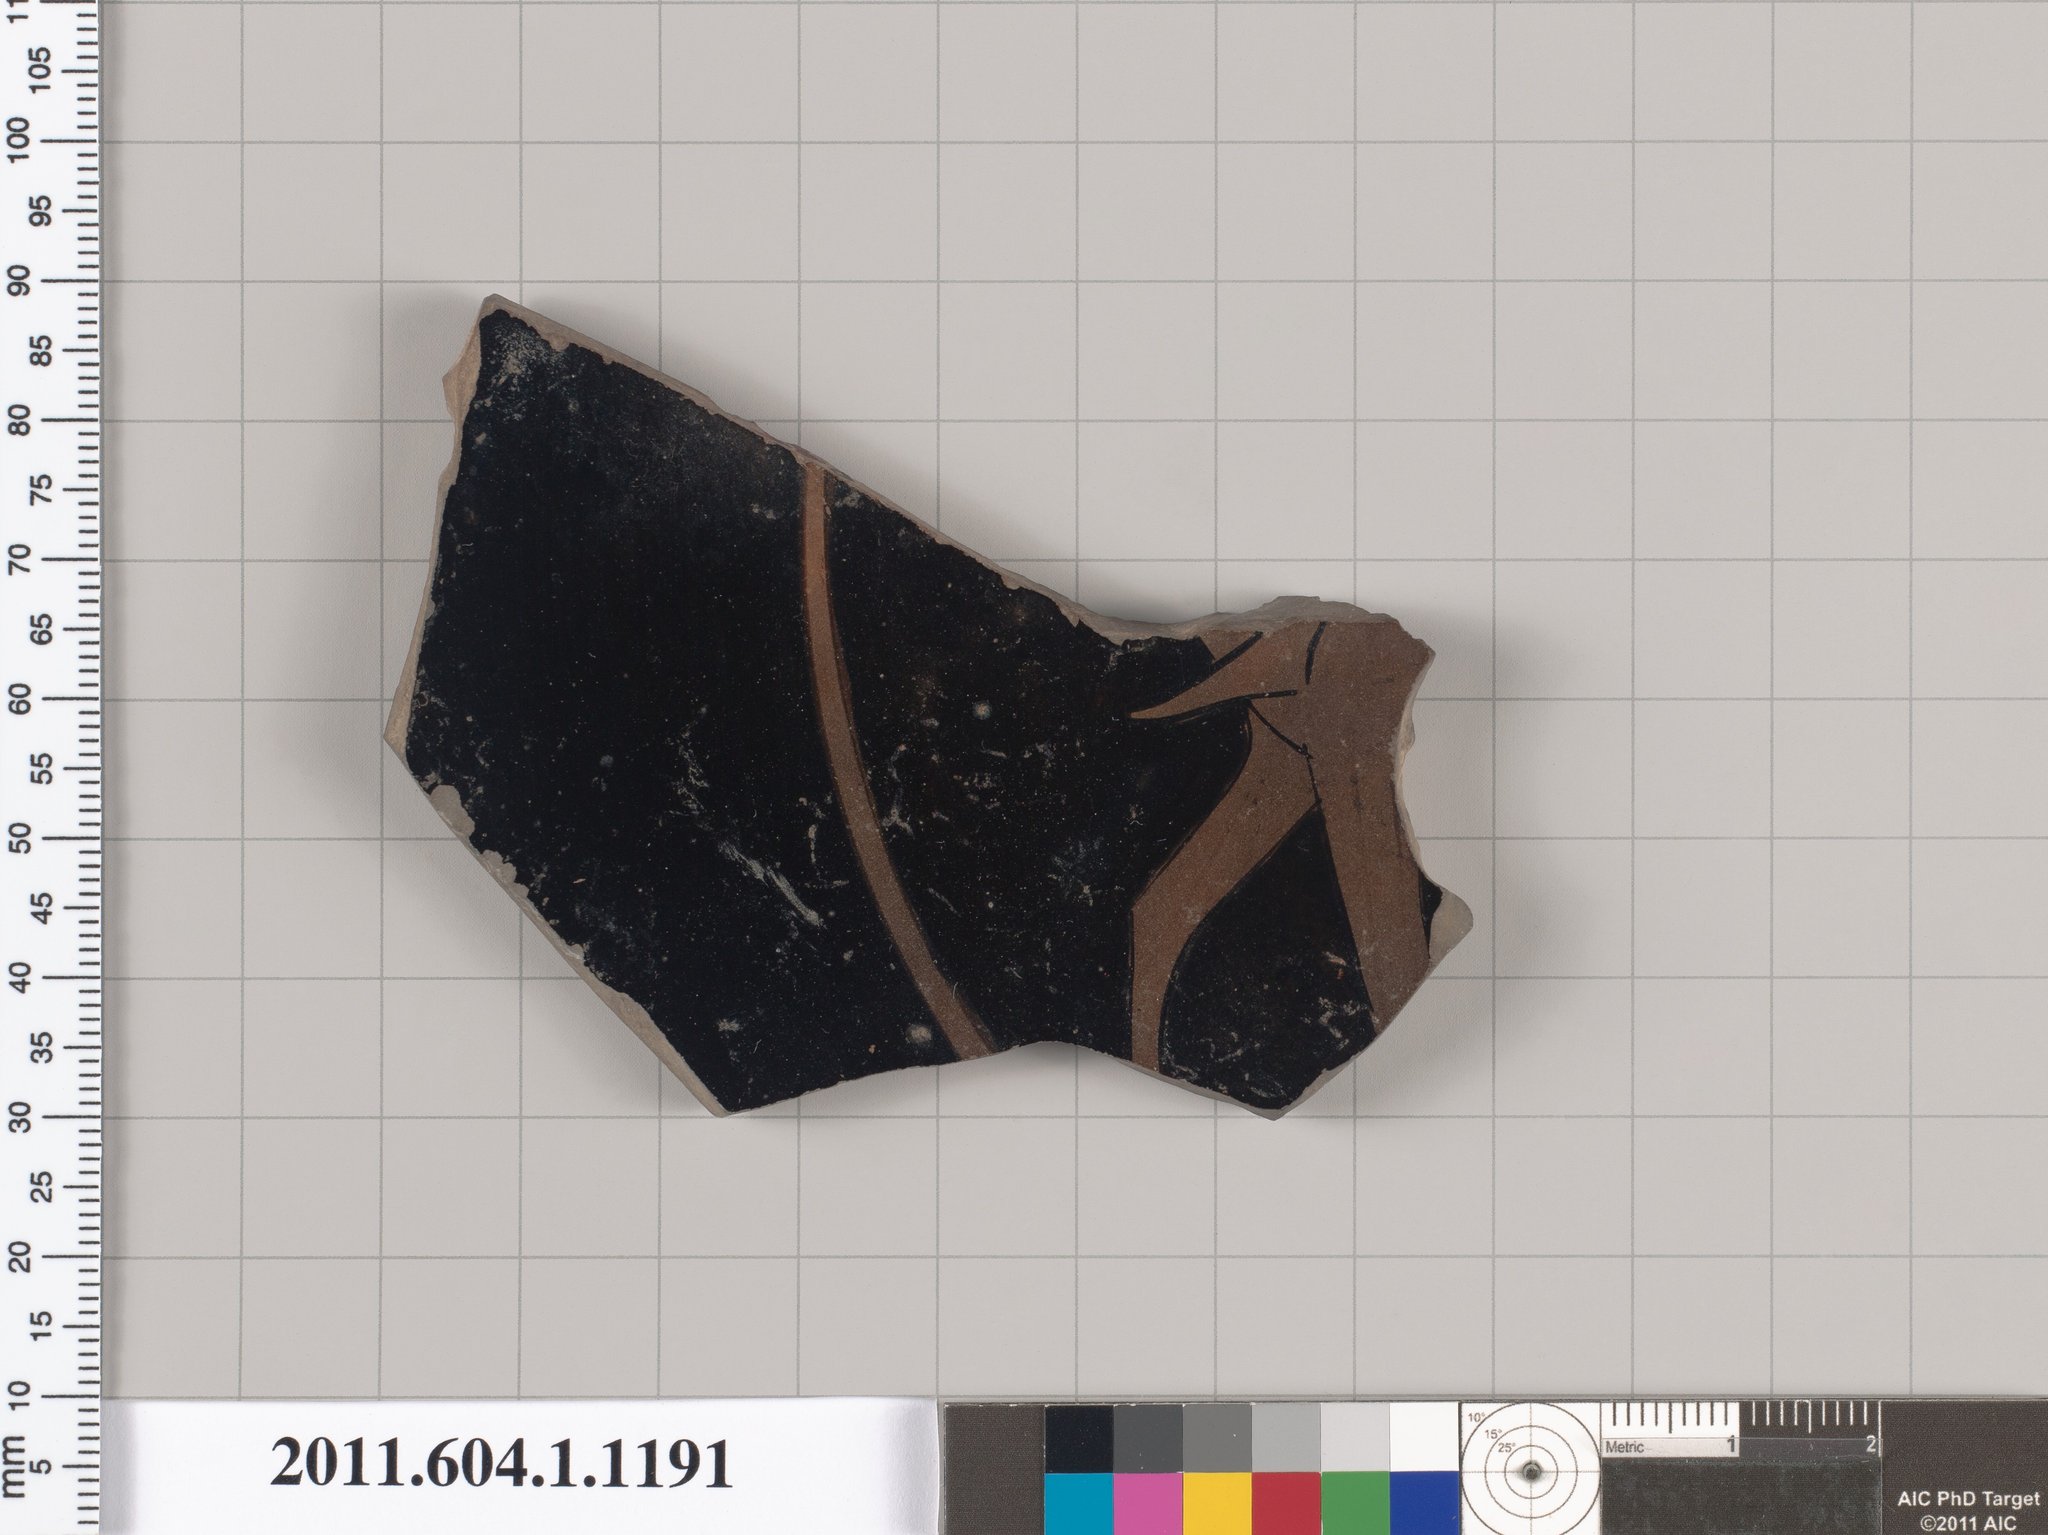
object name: kylix fragment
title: Terracotta fragment of a kylix (drinking cup)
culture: greek, attic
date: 520-500 BCE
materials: terracotta